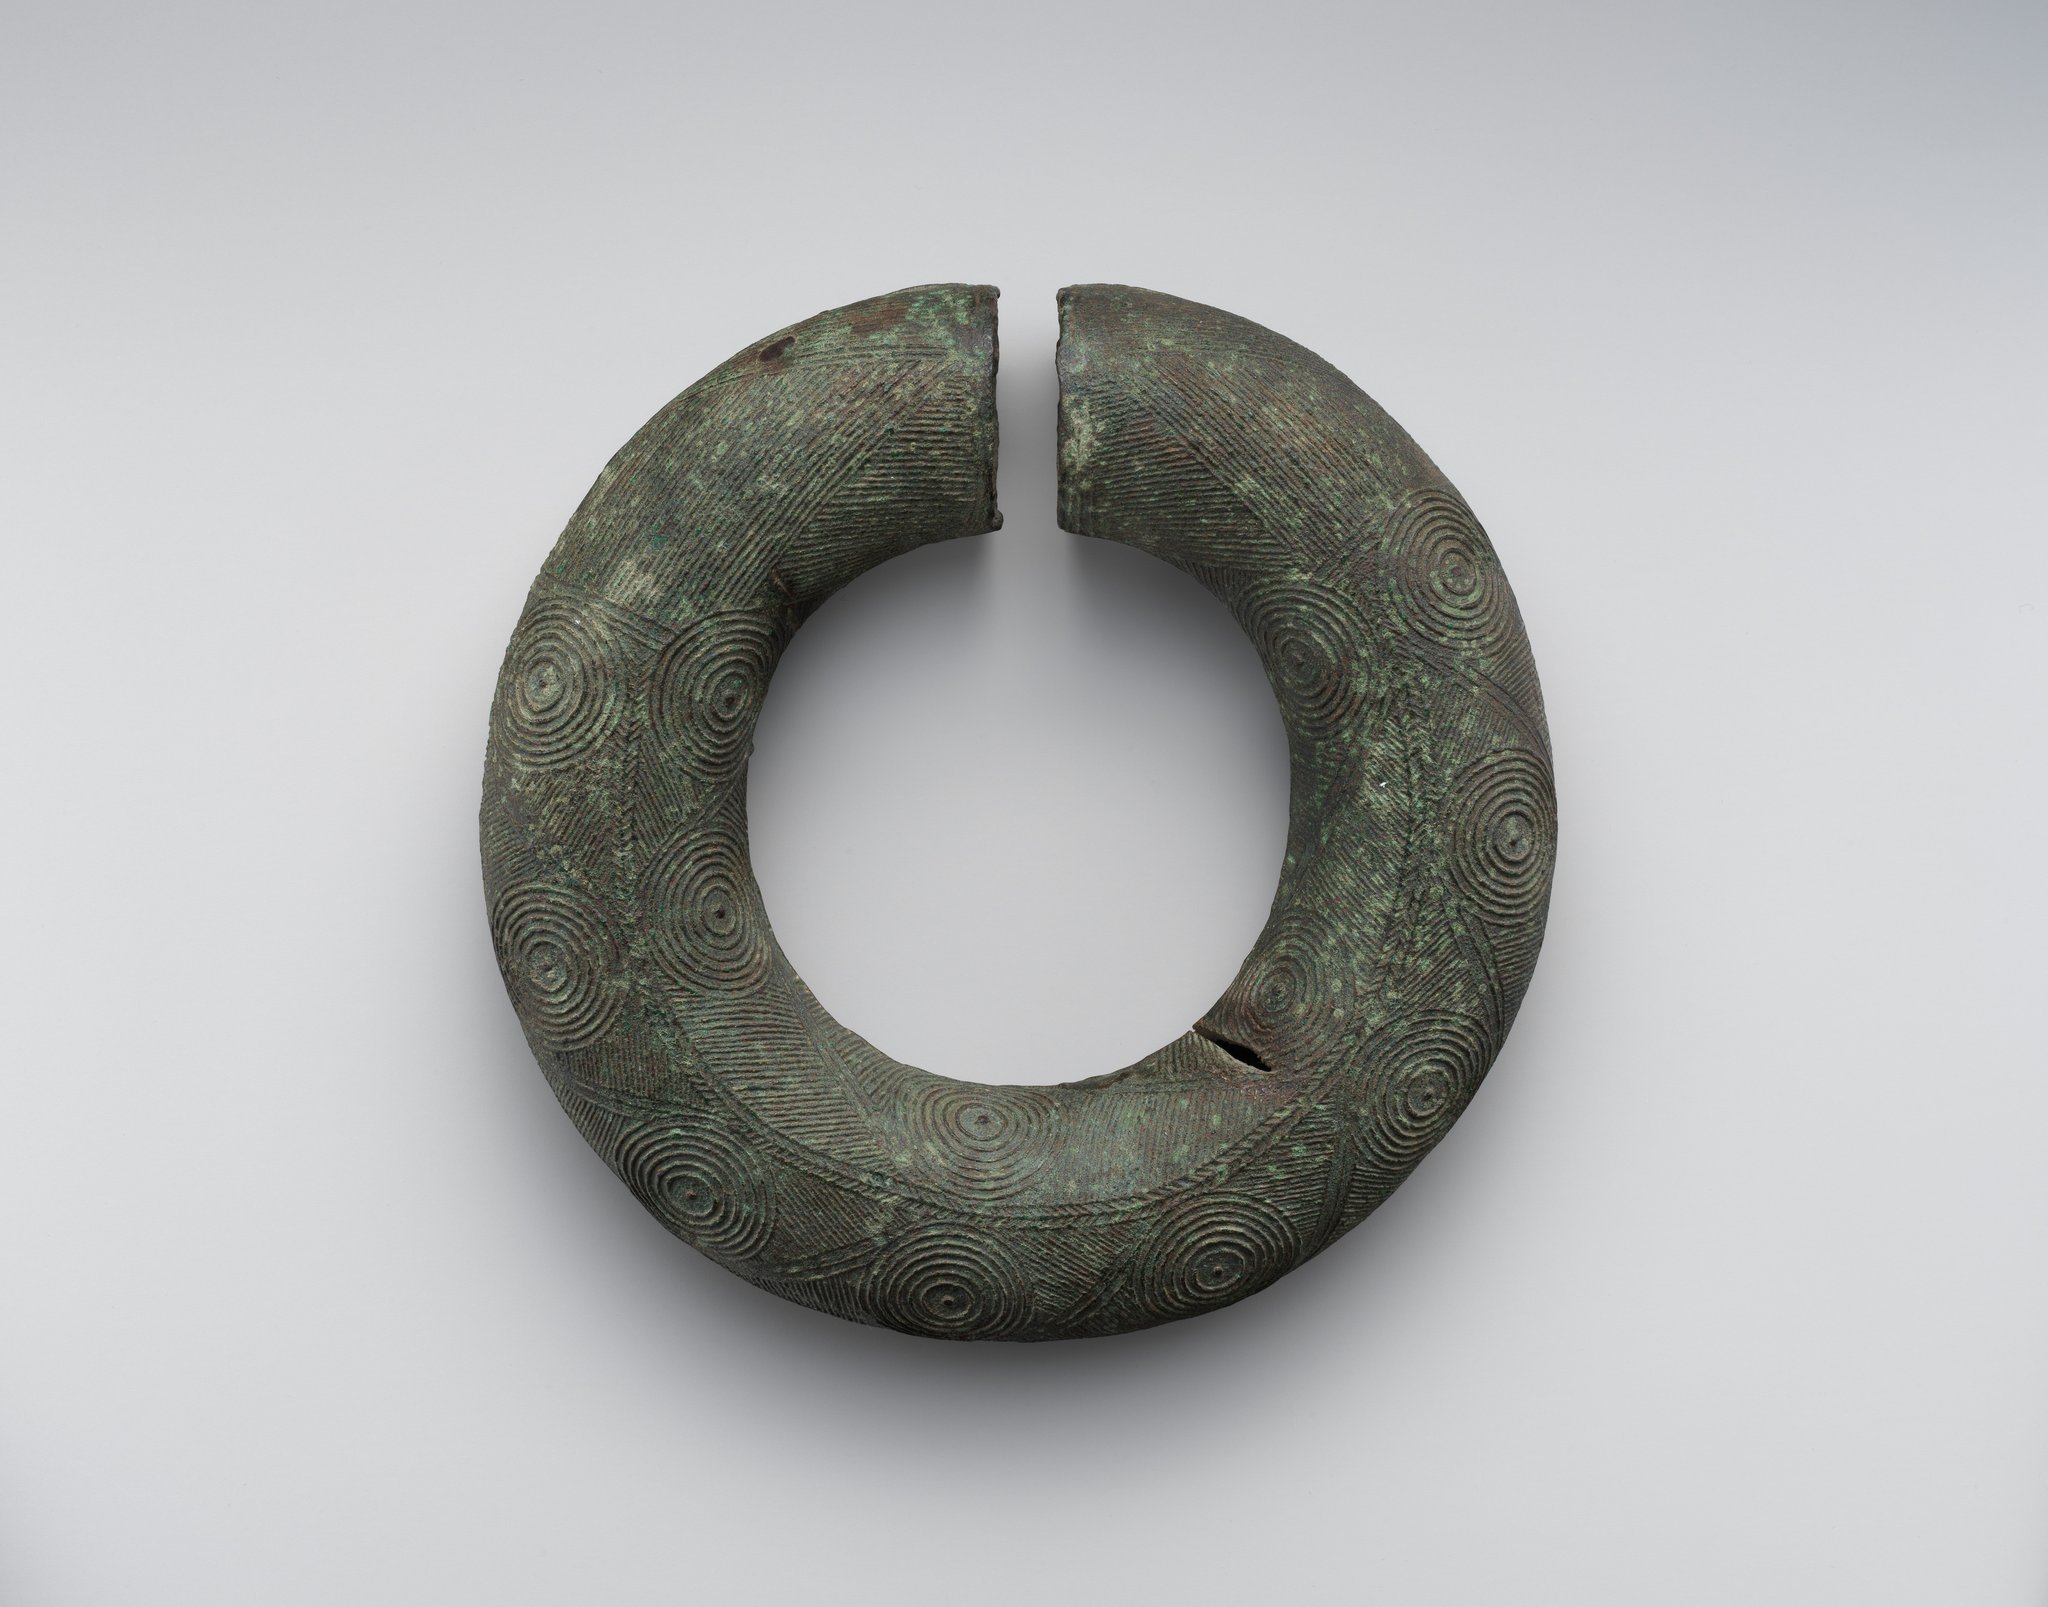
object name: anklet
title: Anklet(?) with Spiral Decoration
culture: thai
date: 300 BCE-200 CE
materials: bronze